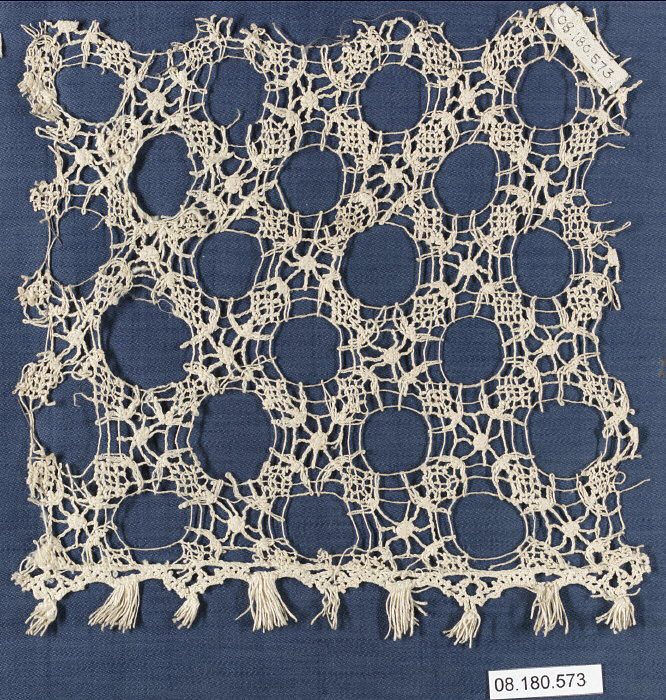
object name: fragment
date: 1601-1700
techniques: embroidery